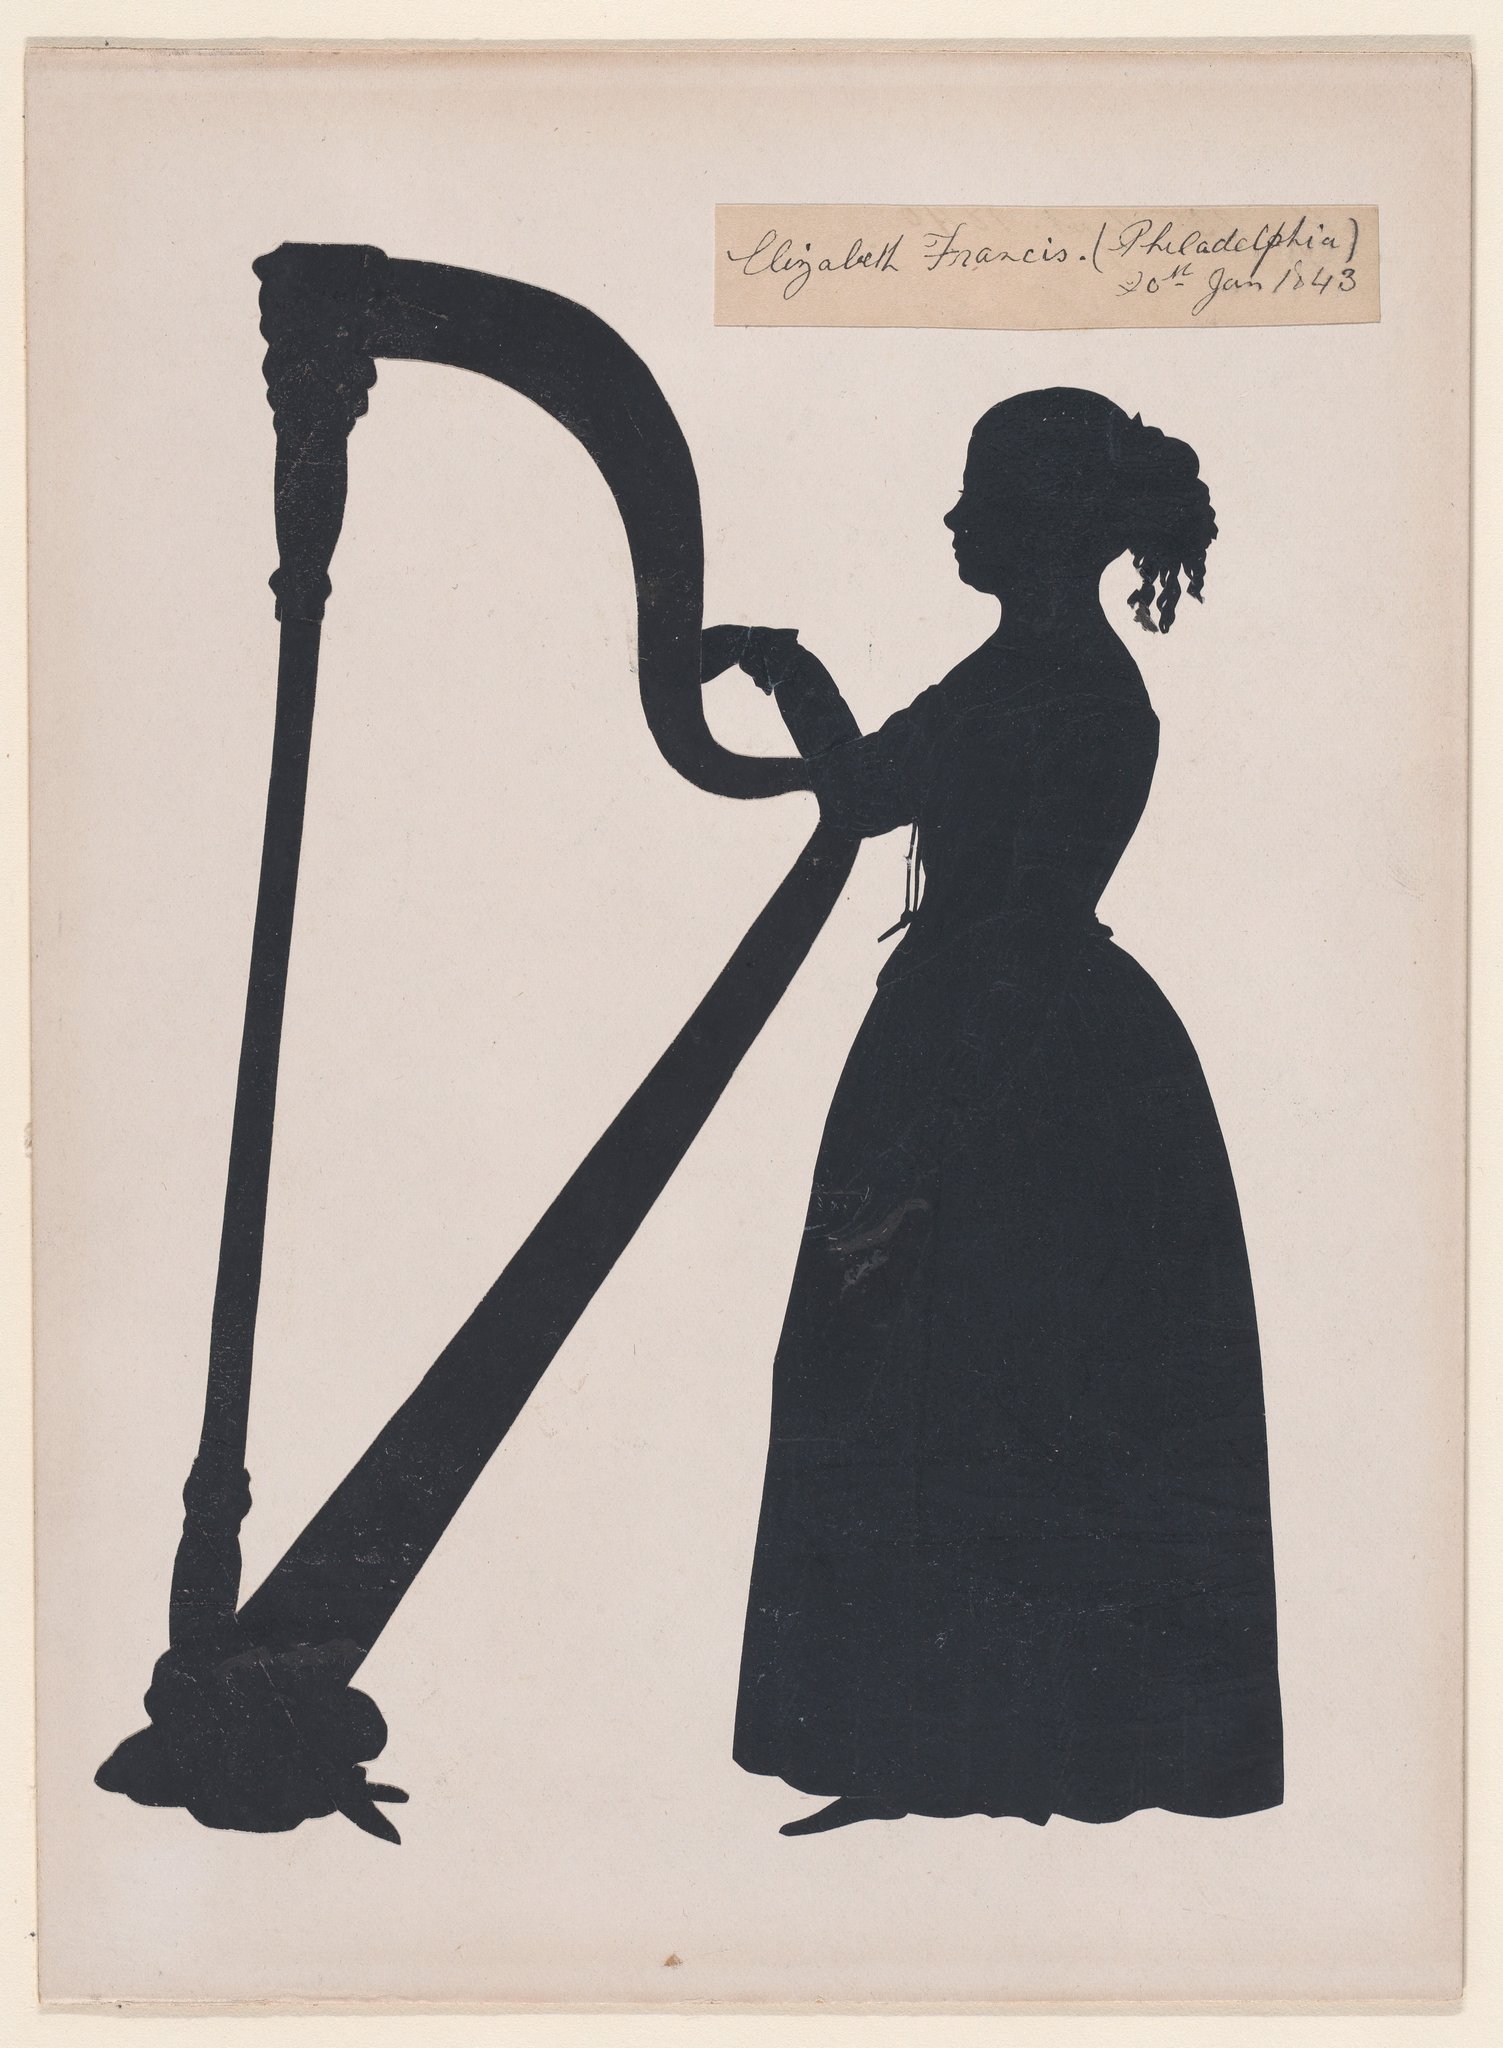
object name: cut paper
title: Elizabeth Francis, standing to the left with a harp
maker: auguste edouart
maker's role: artist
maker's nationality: french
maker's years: 1789-1861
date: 1843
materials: paper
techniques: cutting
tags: women,harps